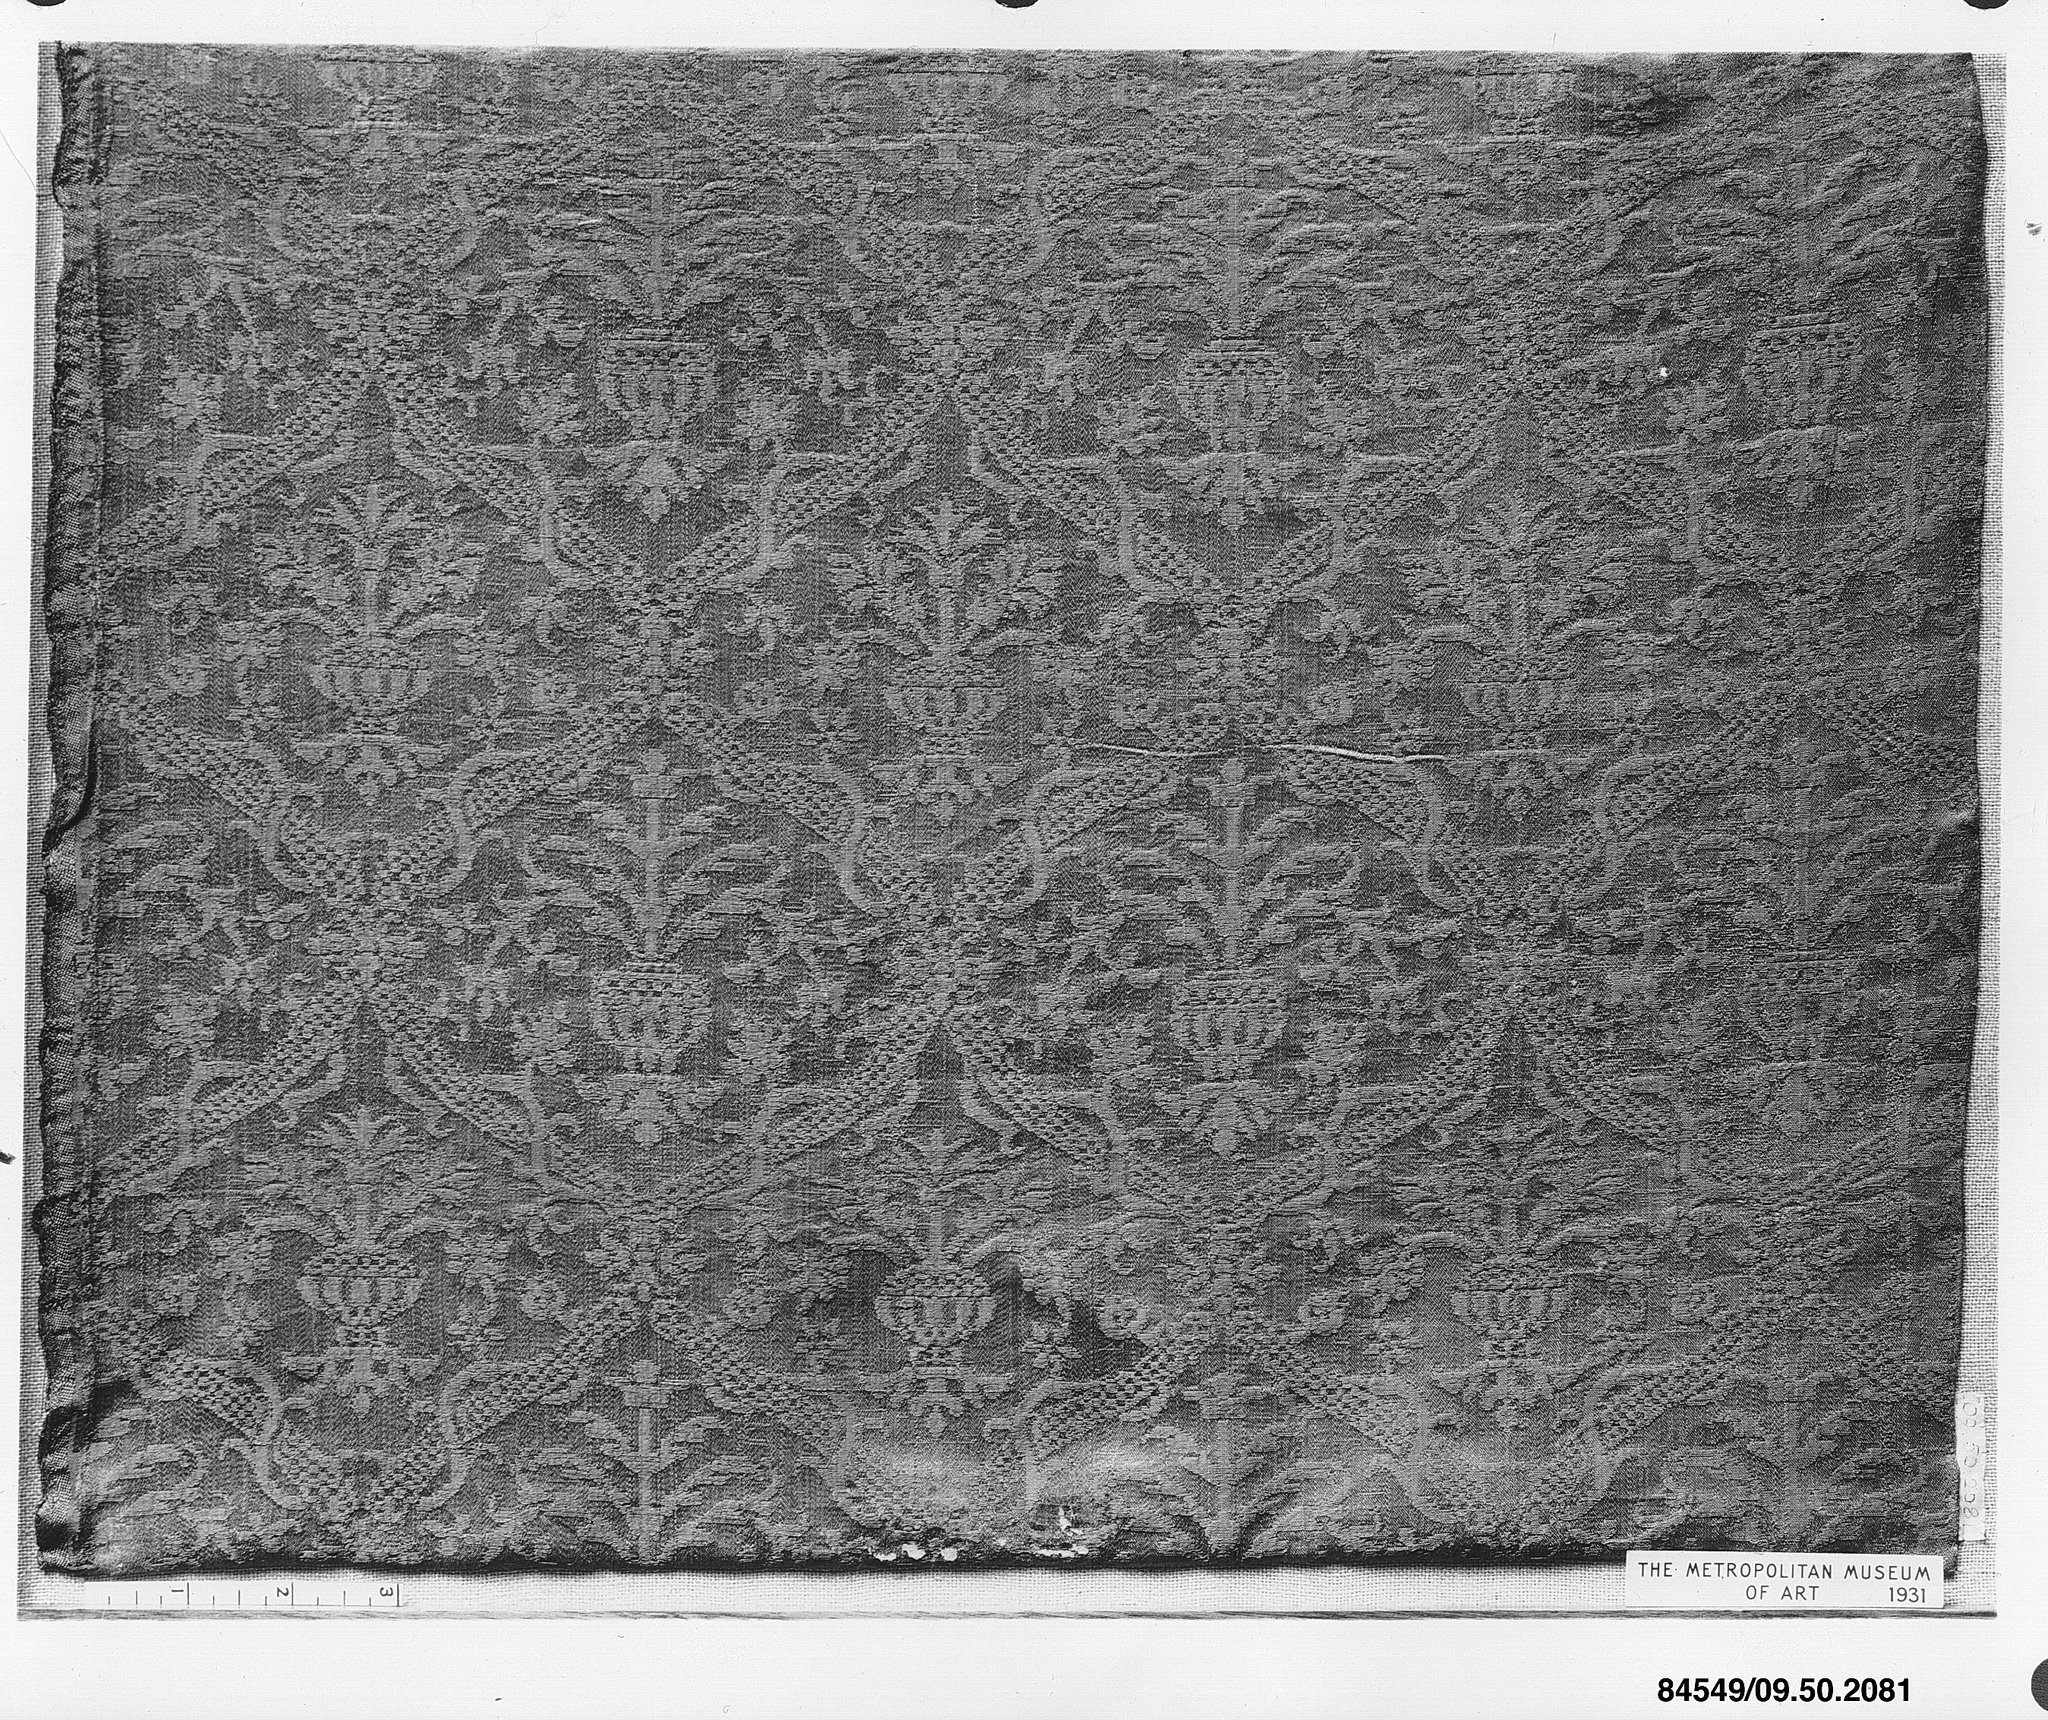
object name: piece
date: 1501-1600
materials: silk